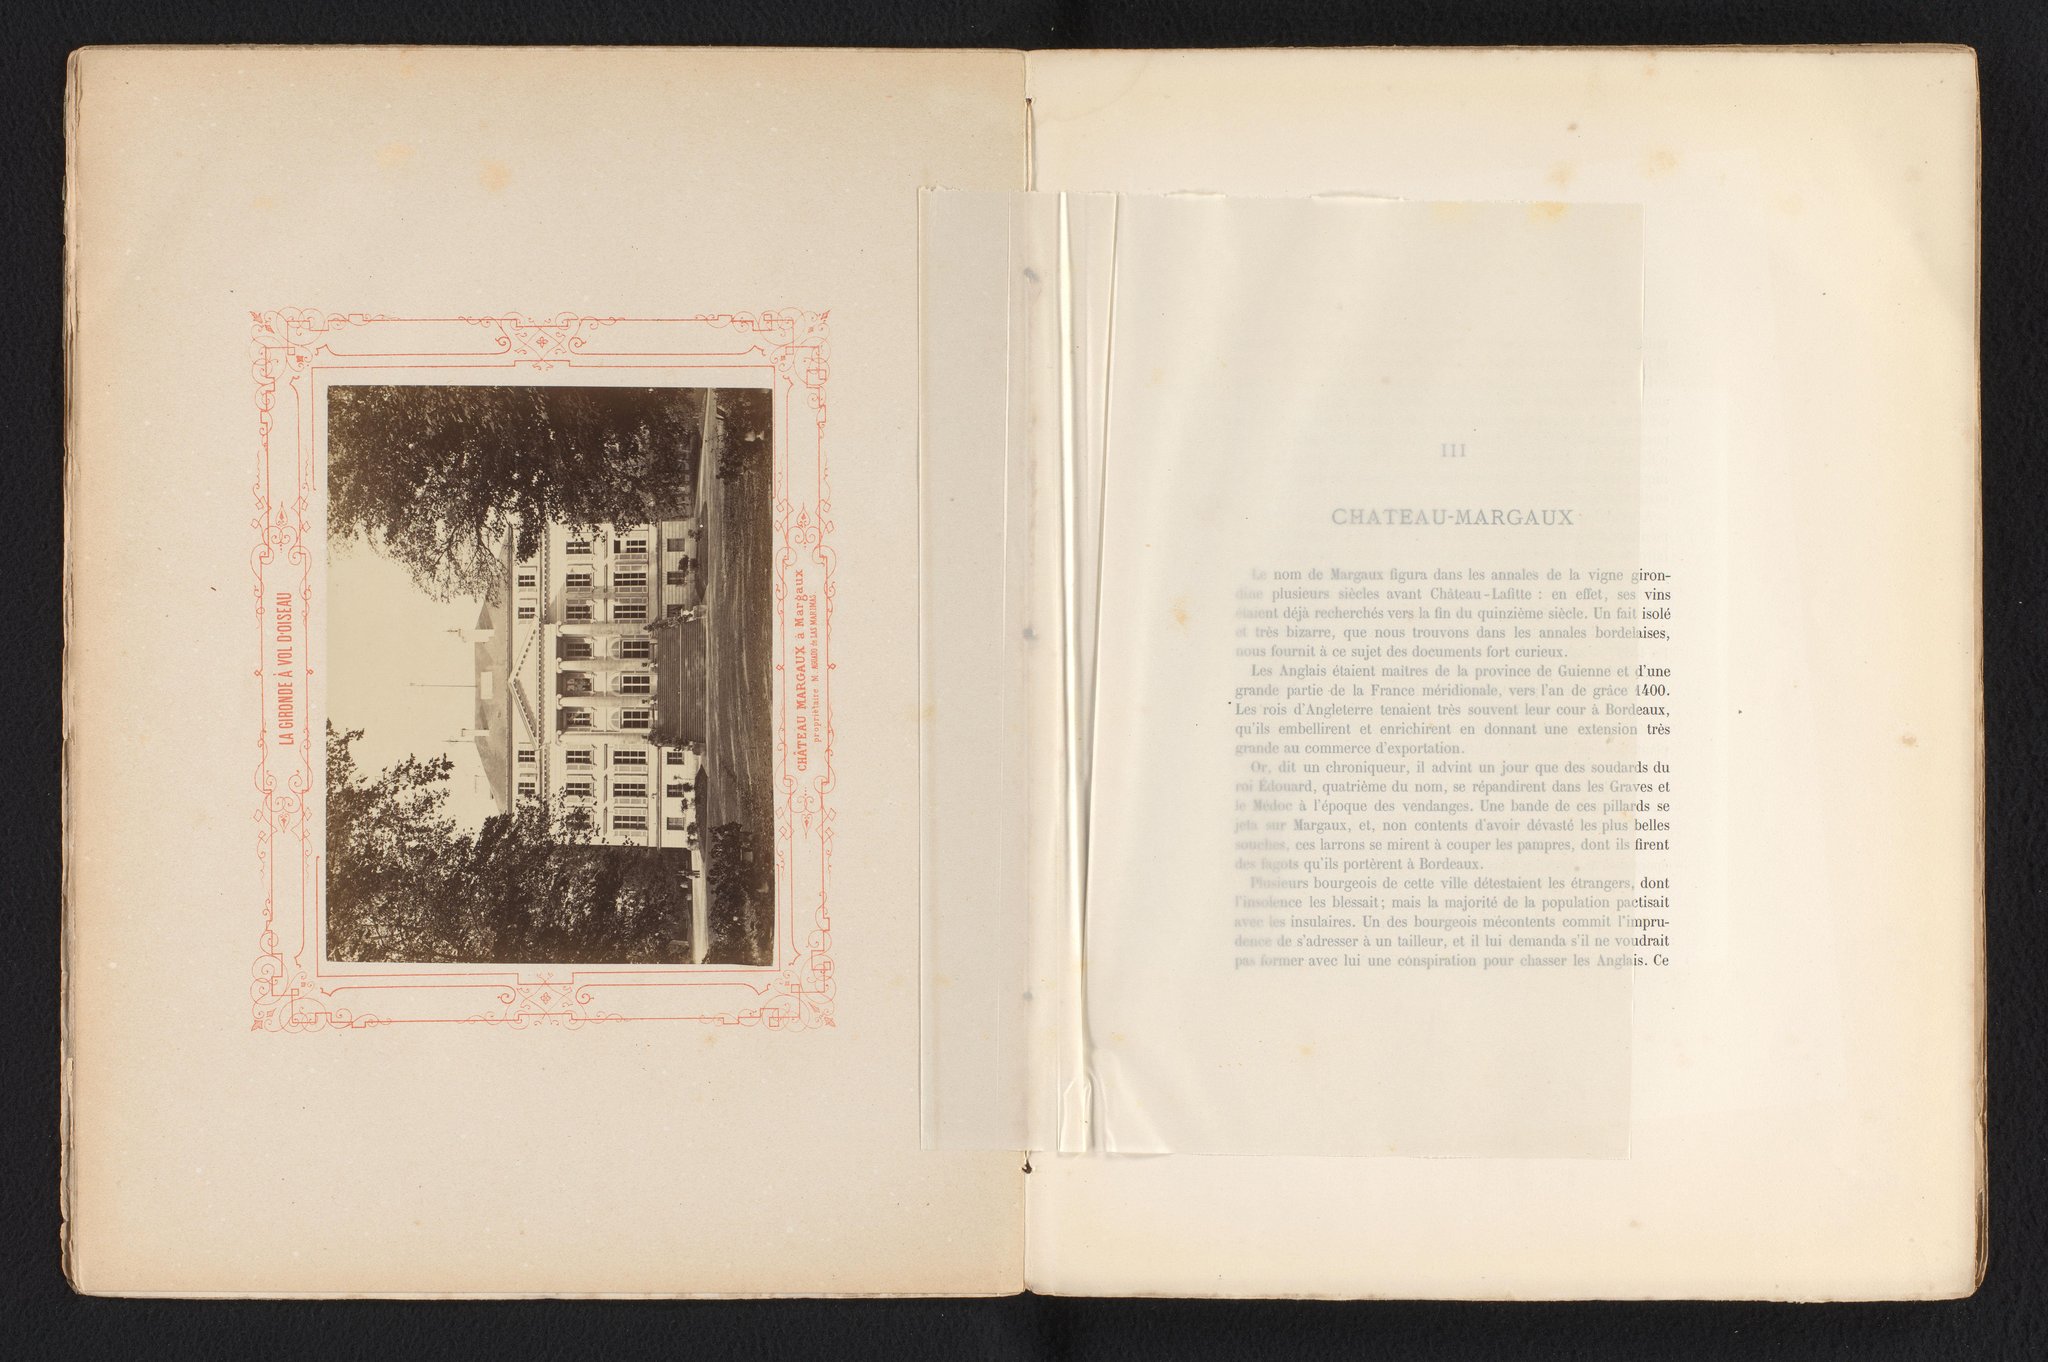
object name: photograph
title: Gezicht op Château Margaux in Margaux, Frankrijk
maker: alfred danflou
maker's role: fotograaf, schrijver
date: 1862-1867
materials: paper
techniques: albumen print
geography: margaux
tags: castle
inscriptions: inscription: ‘propriétaire: M. AGUADO de LAS MARIMAS’